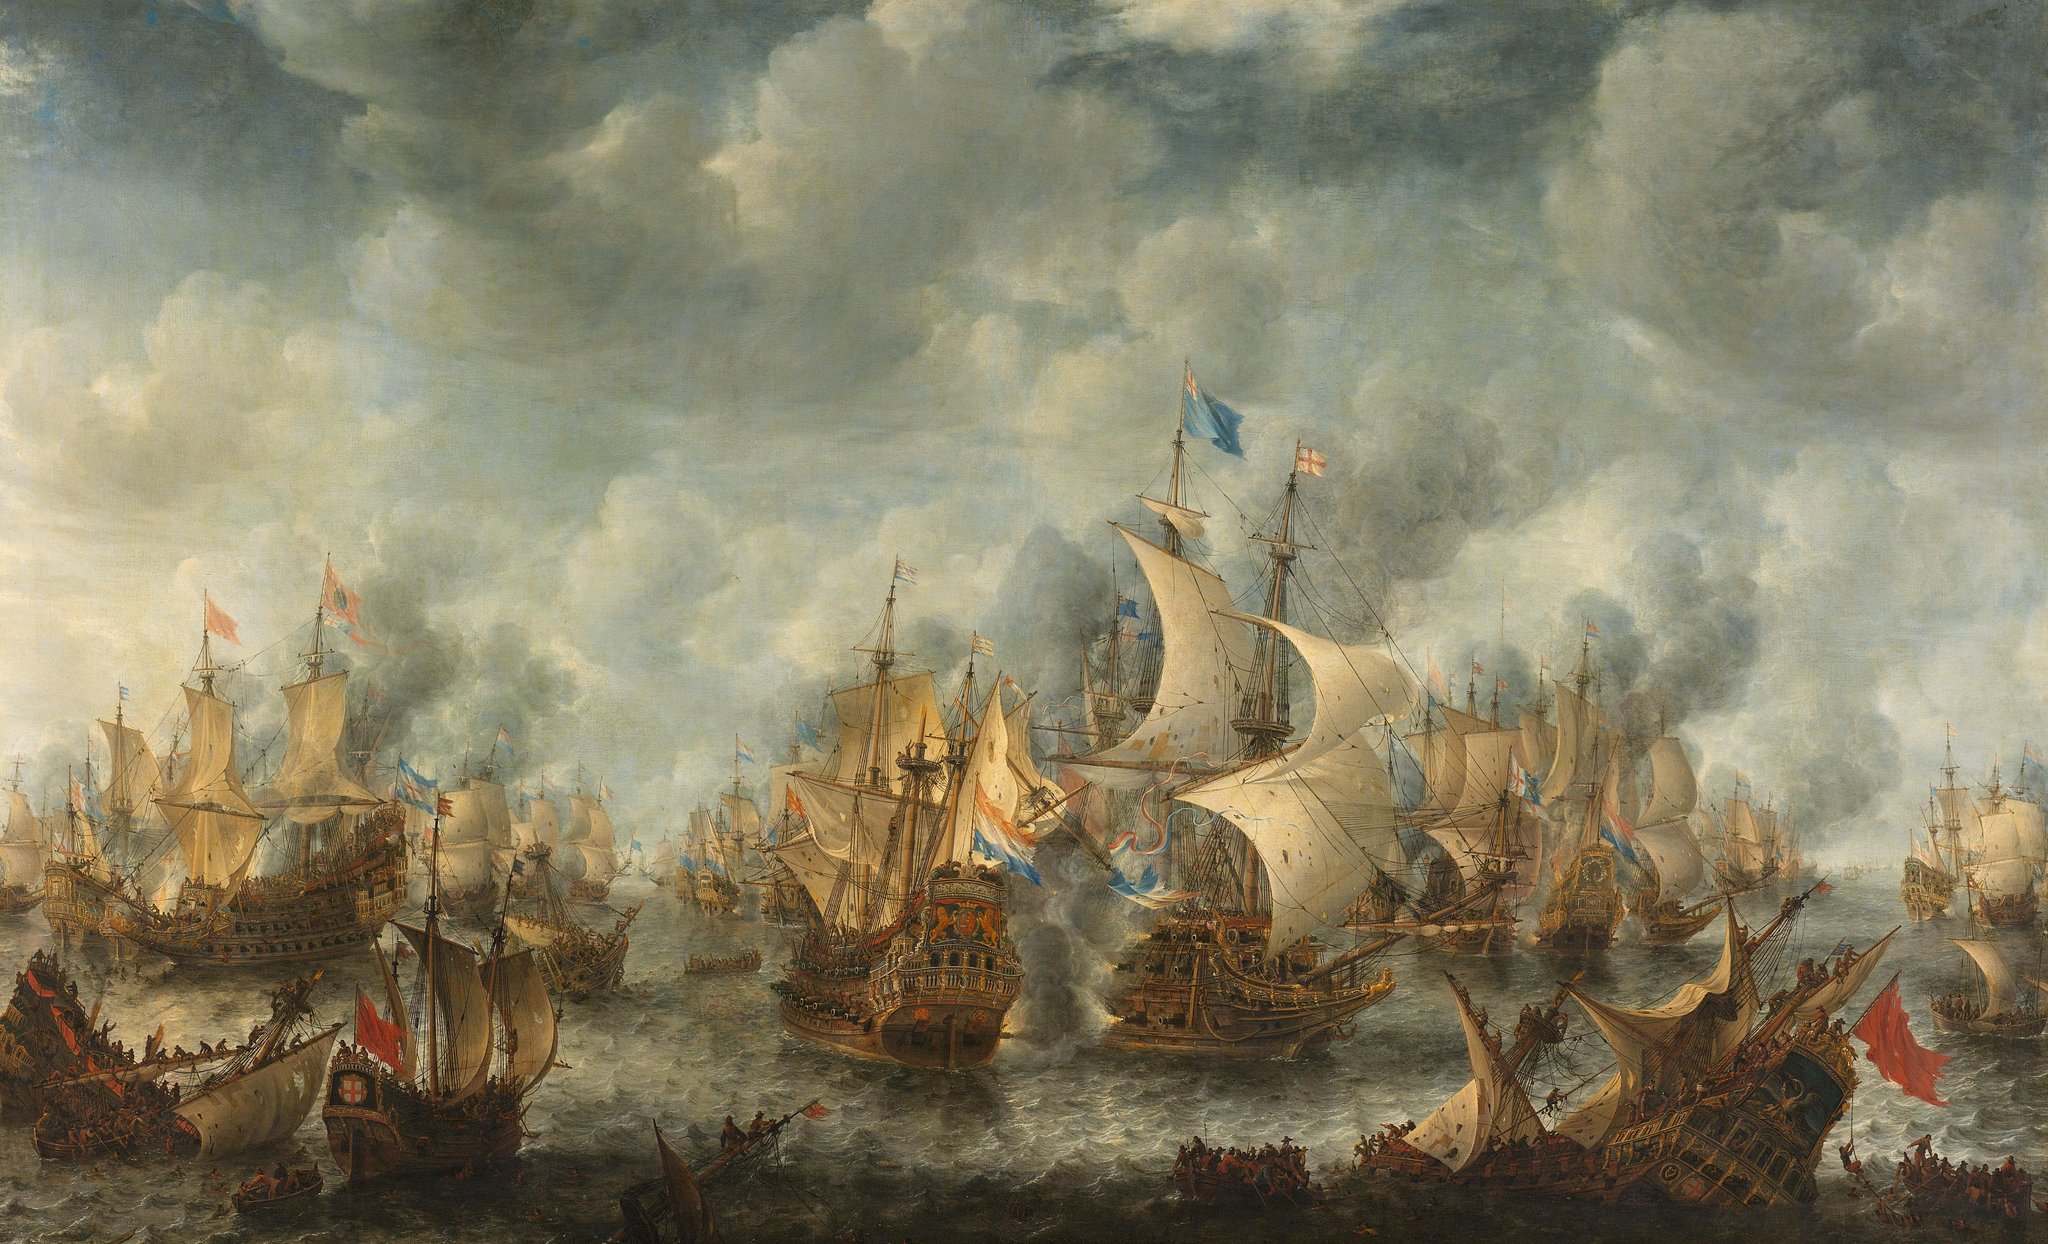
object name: painting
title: The Battle of Terheide, 10 August 1653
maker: jan abrahamsz. beerstraten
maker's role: draughtsman, painter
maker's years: 1622-1666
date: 1653-1666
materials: canvas, oil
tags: maarten harpertszoon tromp, sailing-ship, sailing-boat, battle (+ naval force), battle of scheveningen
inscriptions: signature: ‘I. Beerstraaten.’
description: Between 1652 and 1674, three naval wars were fought with England – the so-called Anglo-Dutch Wars. This painting represents the Battle of Terheide on 10 August 1653. In the centre is the largest vessel in the Dutch fleet, the Brederode, commanded by Admiral Maerten Harpertsz Tromp. It is firing its cannons at an English ship. The Dutch Republic lost the battle, and its commander Tromp, who was fatally wounded.